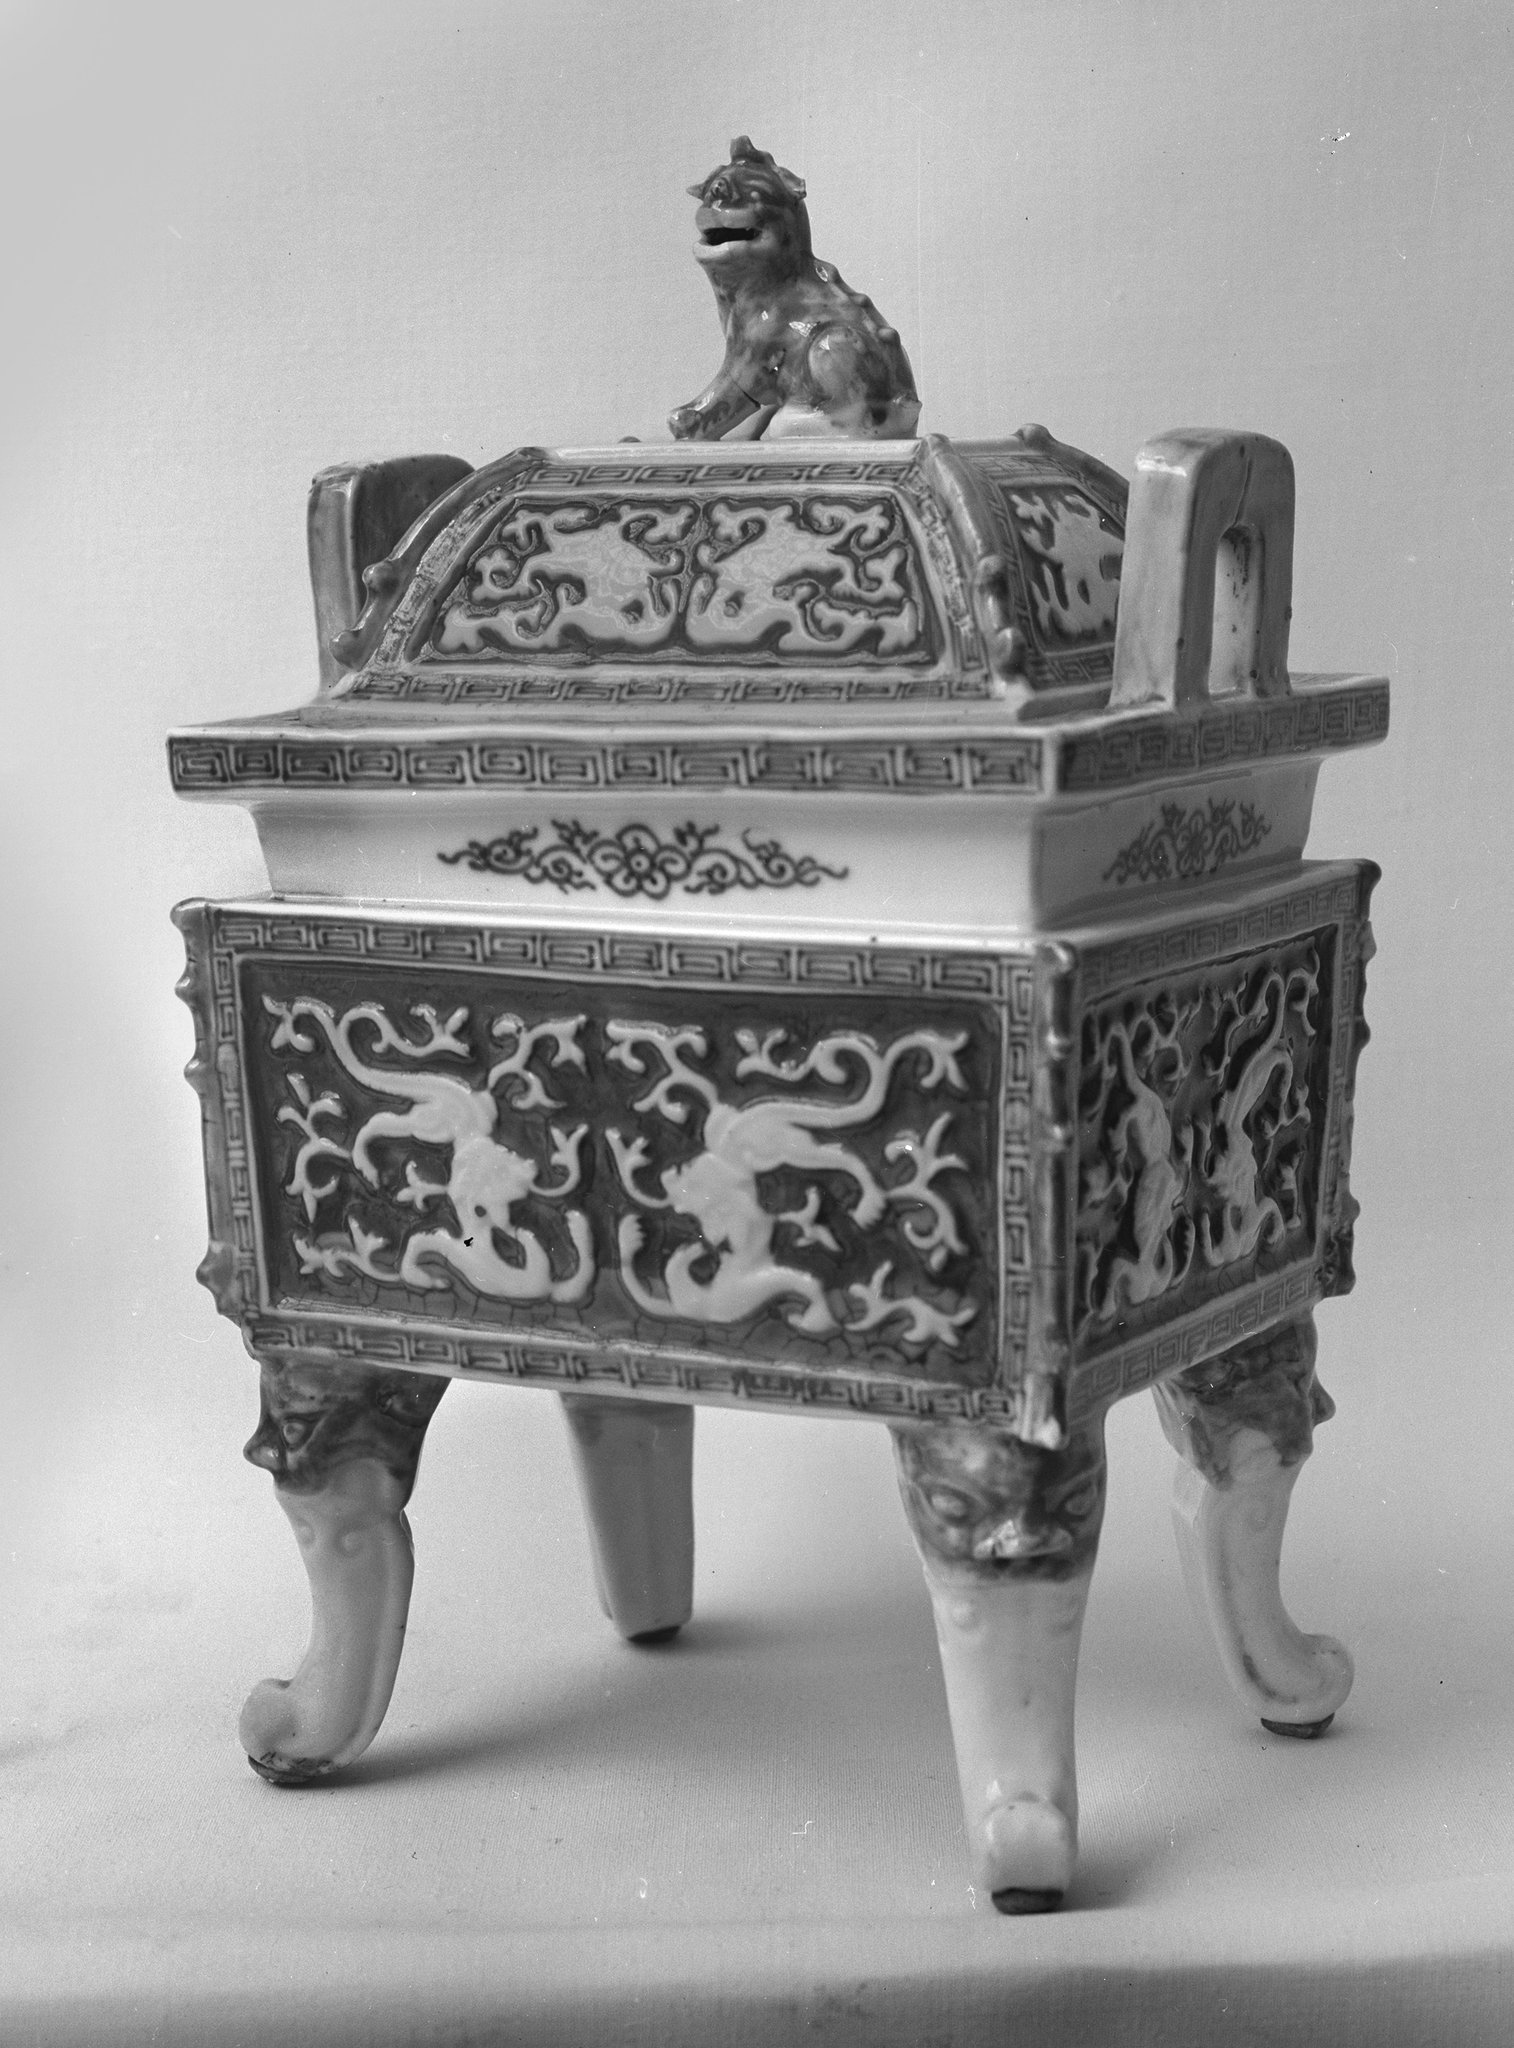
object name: incense burner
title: Covered incense burner with archaistic patterns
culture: chinese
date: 1701-1800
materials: cobalt, porcelain